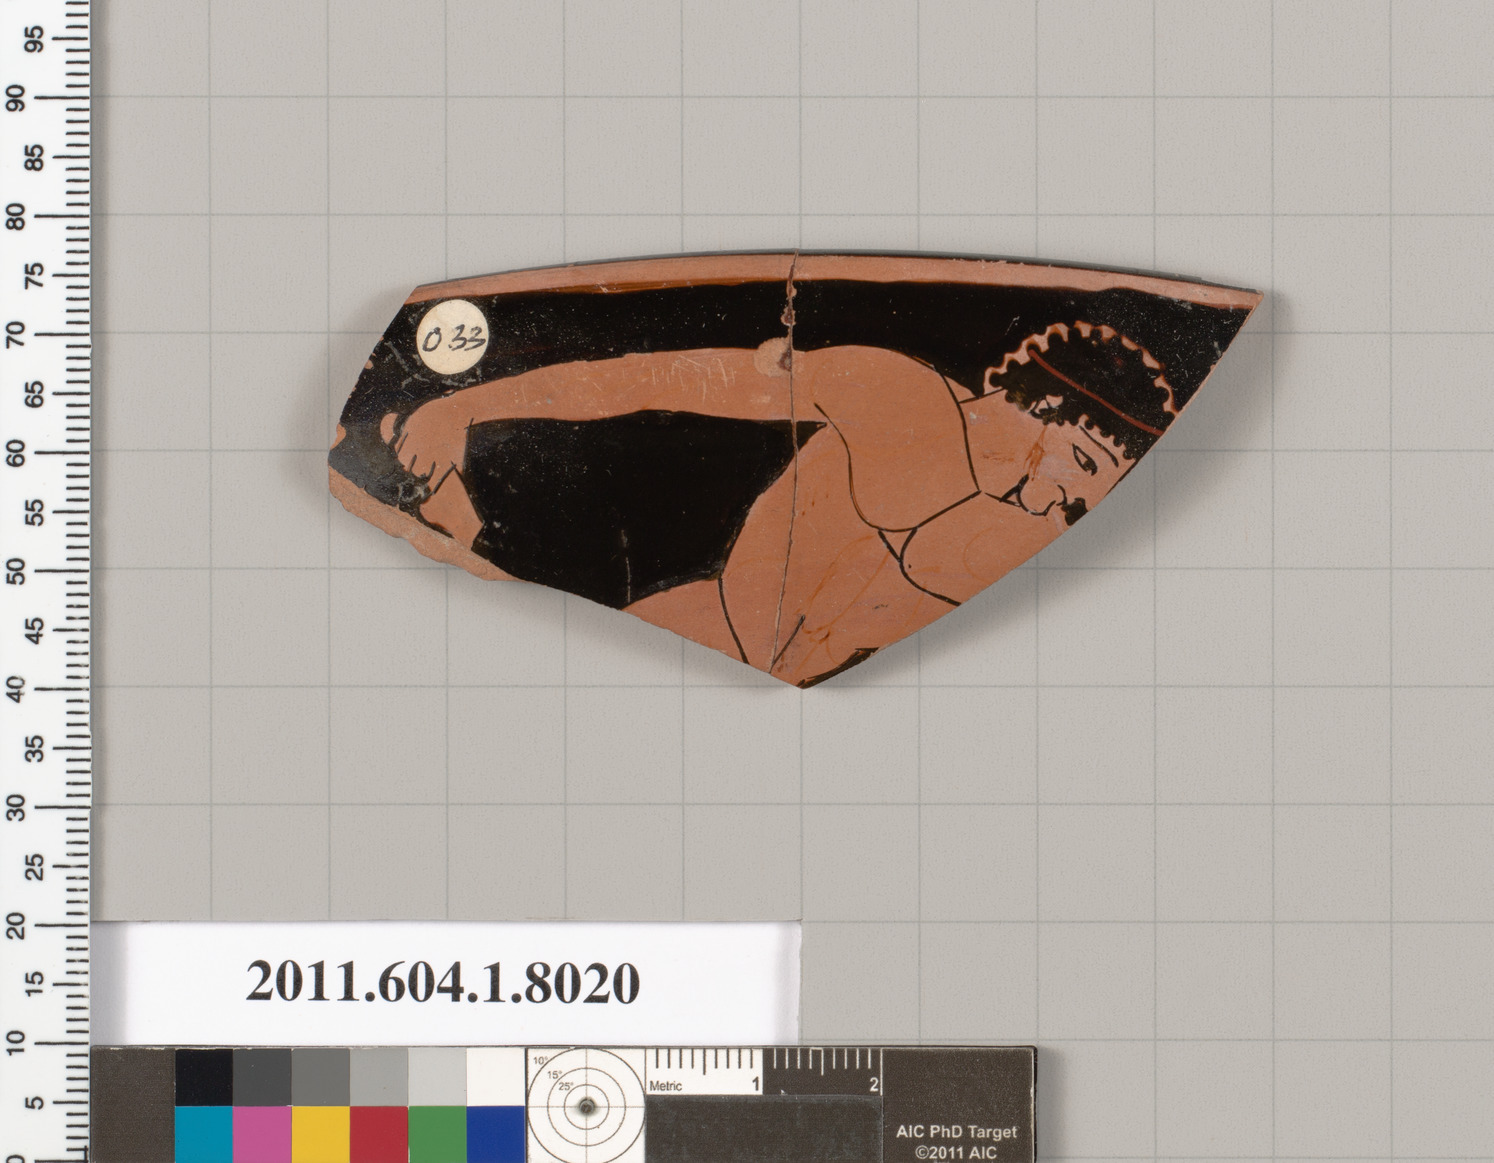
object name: kylix fragment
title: Terracotta rim fragment of a kylix (drinking cup)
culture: greek, attic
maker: triptolemos painter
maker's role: artist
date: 500-480 BCE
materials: terracotta